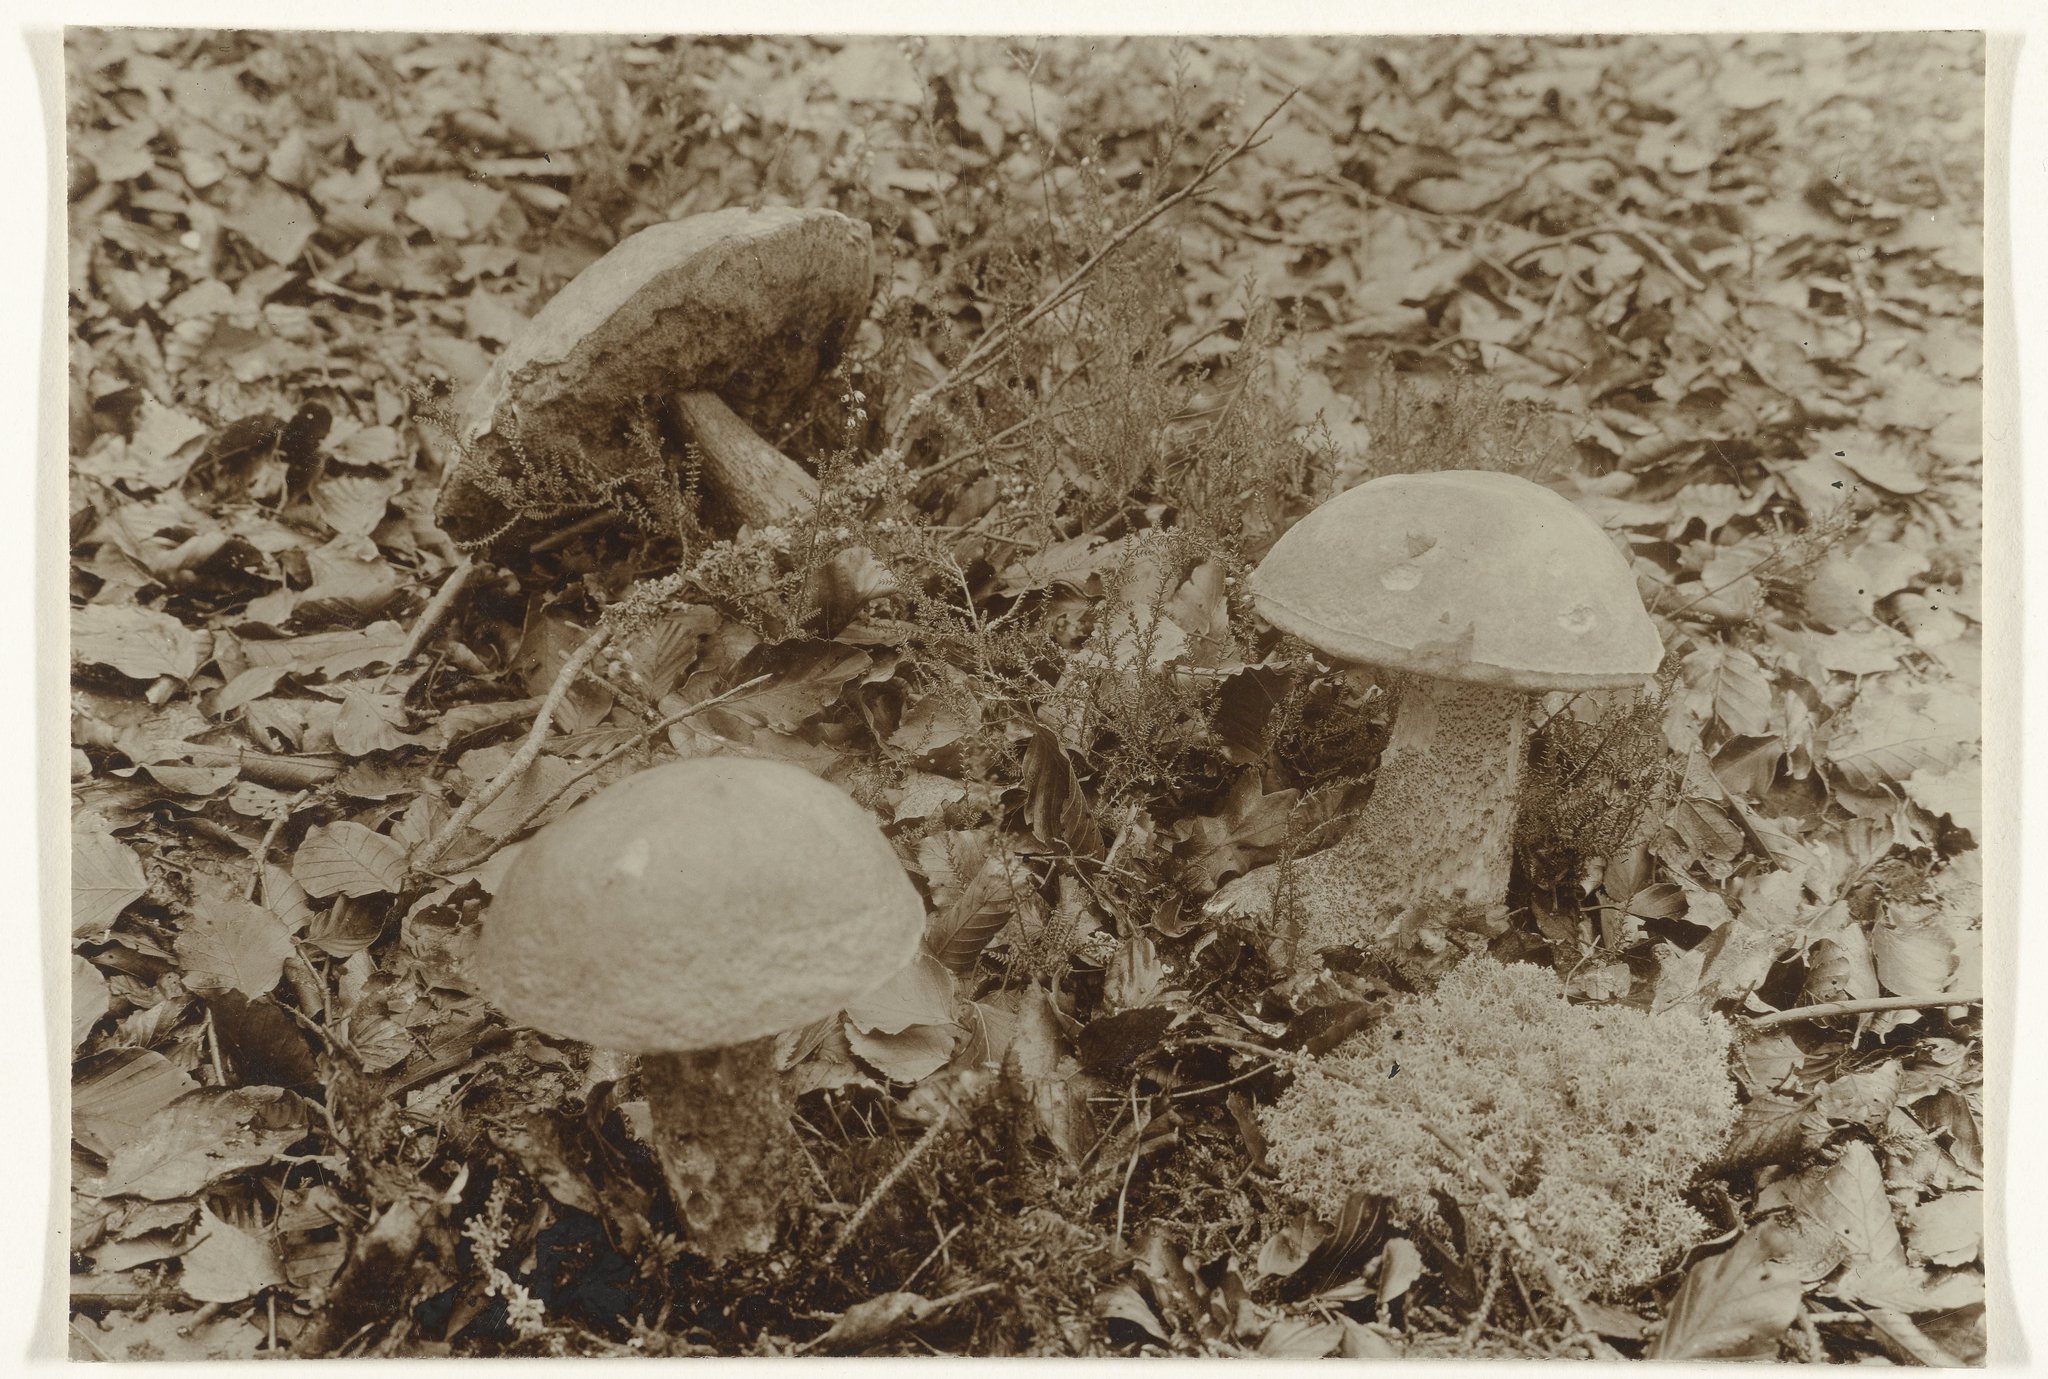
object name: photograph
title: Berkenboleet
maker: richard tepe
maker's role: fotograaf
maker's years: 1864-1952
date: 1900-1930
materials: photographic support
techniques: gelatin silver print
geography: netherlands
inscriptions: annotation: ‘Berkenboleet / Boletus scaber’, signature: ‘foto / R Tepe’